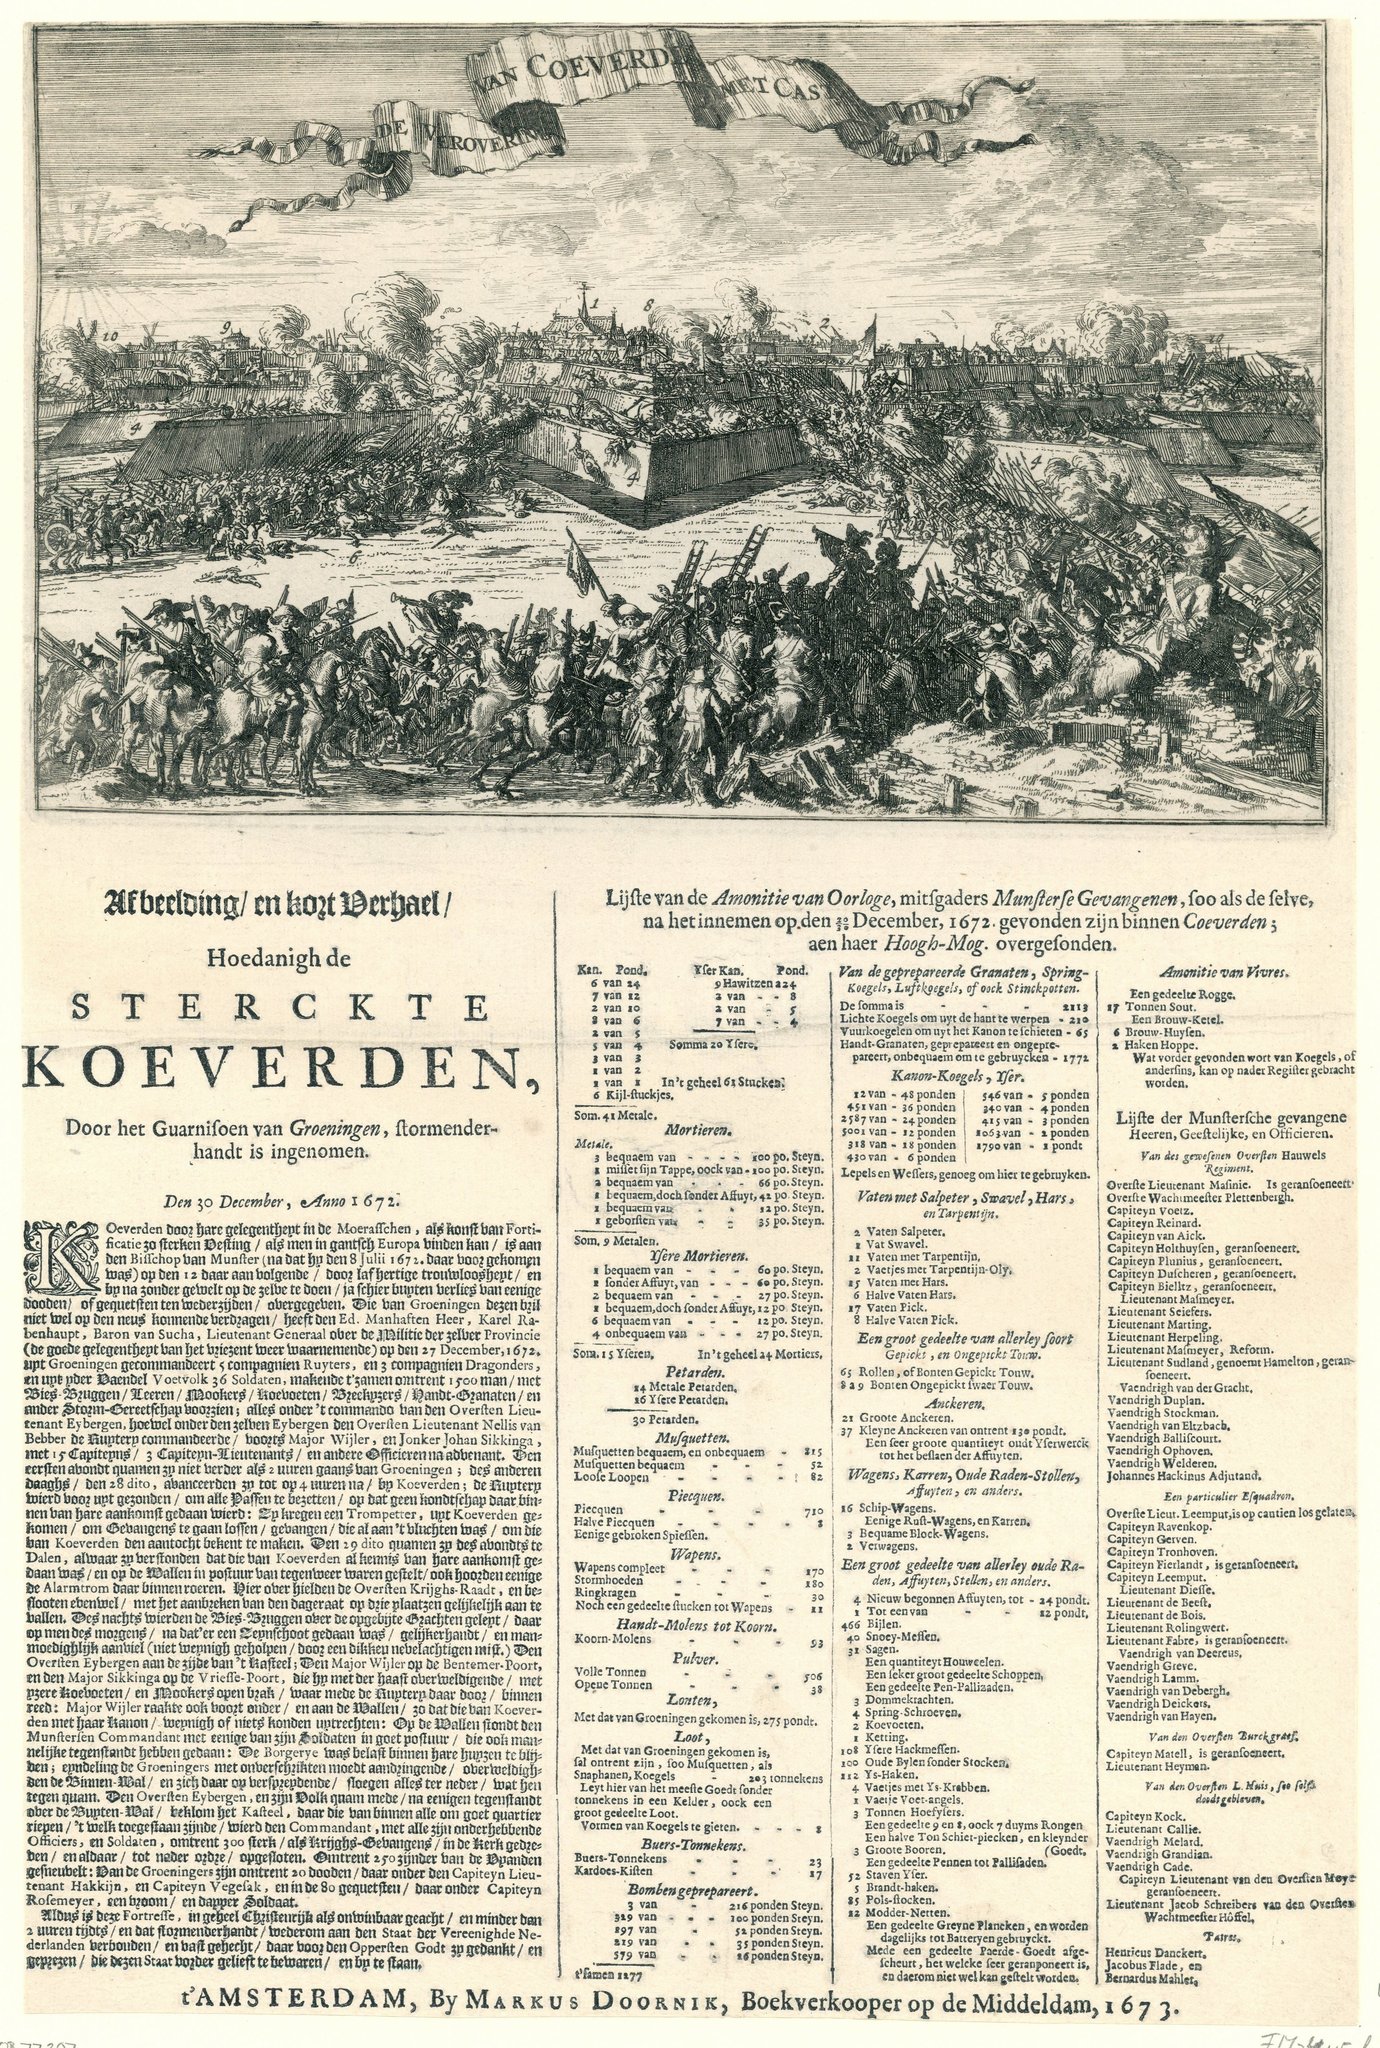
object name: print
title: Afbeelding en kort Verhael Hoedanigh de Sterckte Koeverden, Door het Guarnisoen van Groeningen, stormenderhandt is ingenomen. Den 30 December, Anno 1672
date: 1673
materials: paper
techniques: etching, letterpress printing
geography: northern netherlands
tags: capture of city (after the siege)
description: Blad met een voorstelling en beschrijving van de verovering van Coevorden op 30 december 1672 op de troepen van de bisschop van Munster, door de troepen onder leiding van Karl Rabenhaupt. De plaat is verkleind en de legenda voor de genummerde details ontbreekt bij deze staat van de prent. Onder de voorstelling staat een beschrijving van het verloop van de strijd. Hiernaast staat over drie kolommen een gedetailleerd overzicht van alle gemaakte gevangenen, met naam en rang, en een lijst van de veroverde wapens en voorraden.